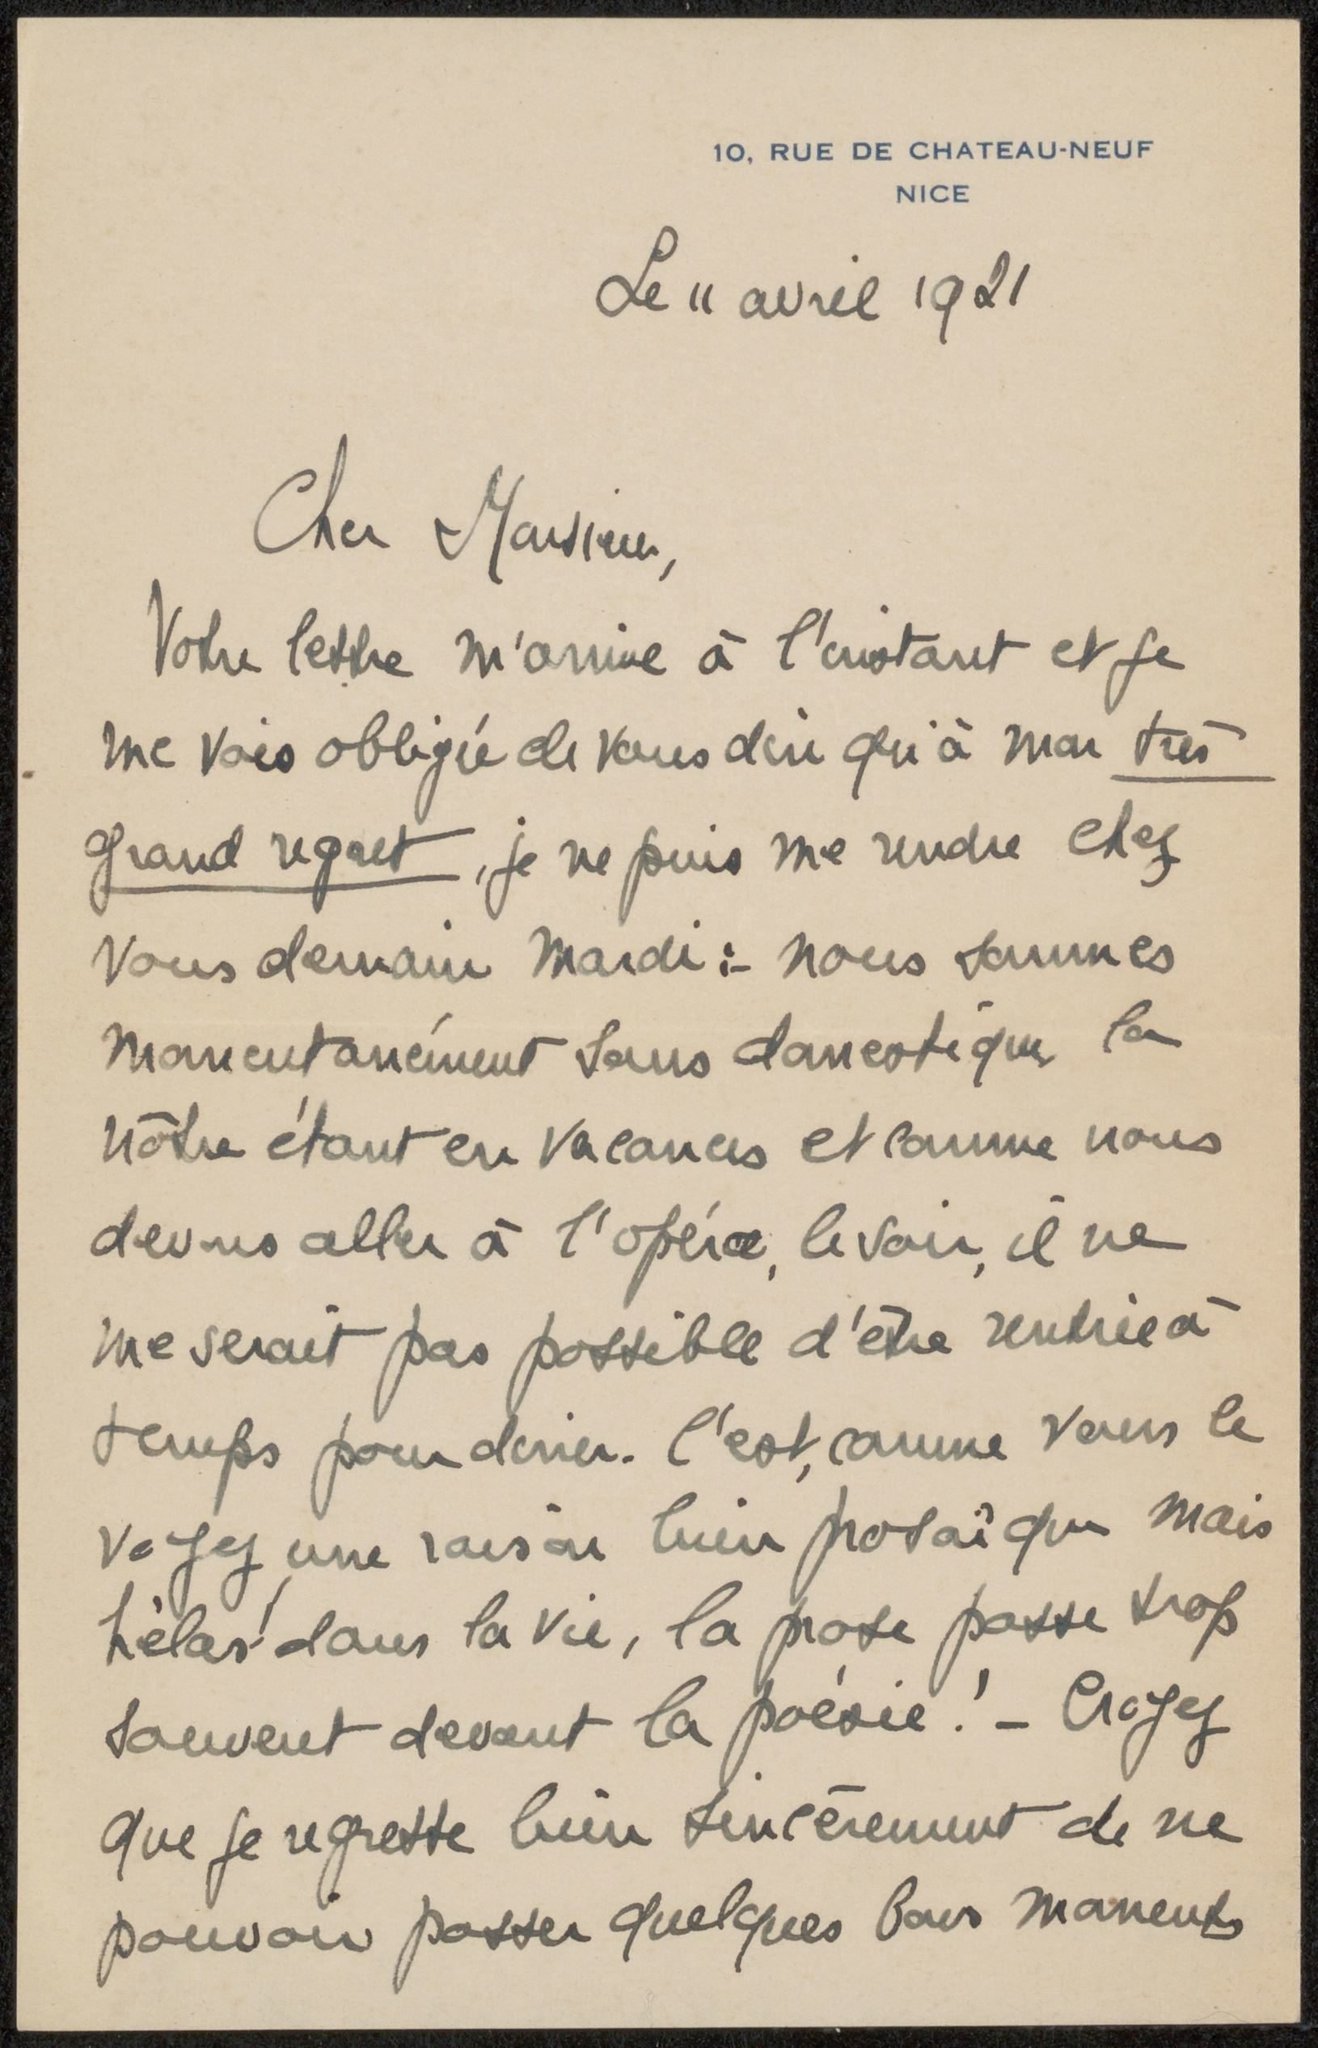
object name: letter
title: Brief aan Philip Zilcken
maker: jeanne erlich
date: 1921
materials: ink, paper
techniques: pen, printing, writing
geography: nice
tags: the hague, painter, draughtsman, philip zilcken, literature ~ arts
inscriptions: collector's mark: ‘RPK’